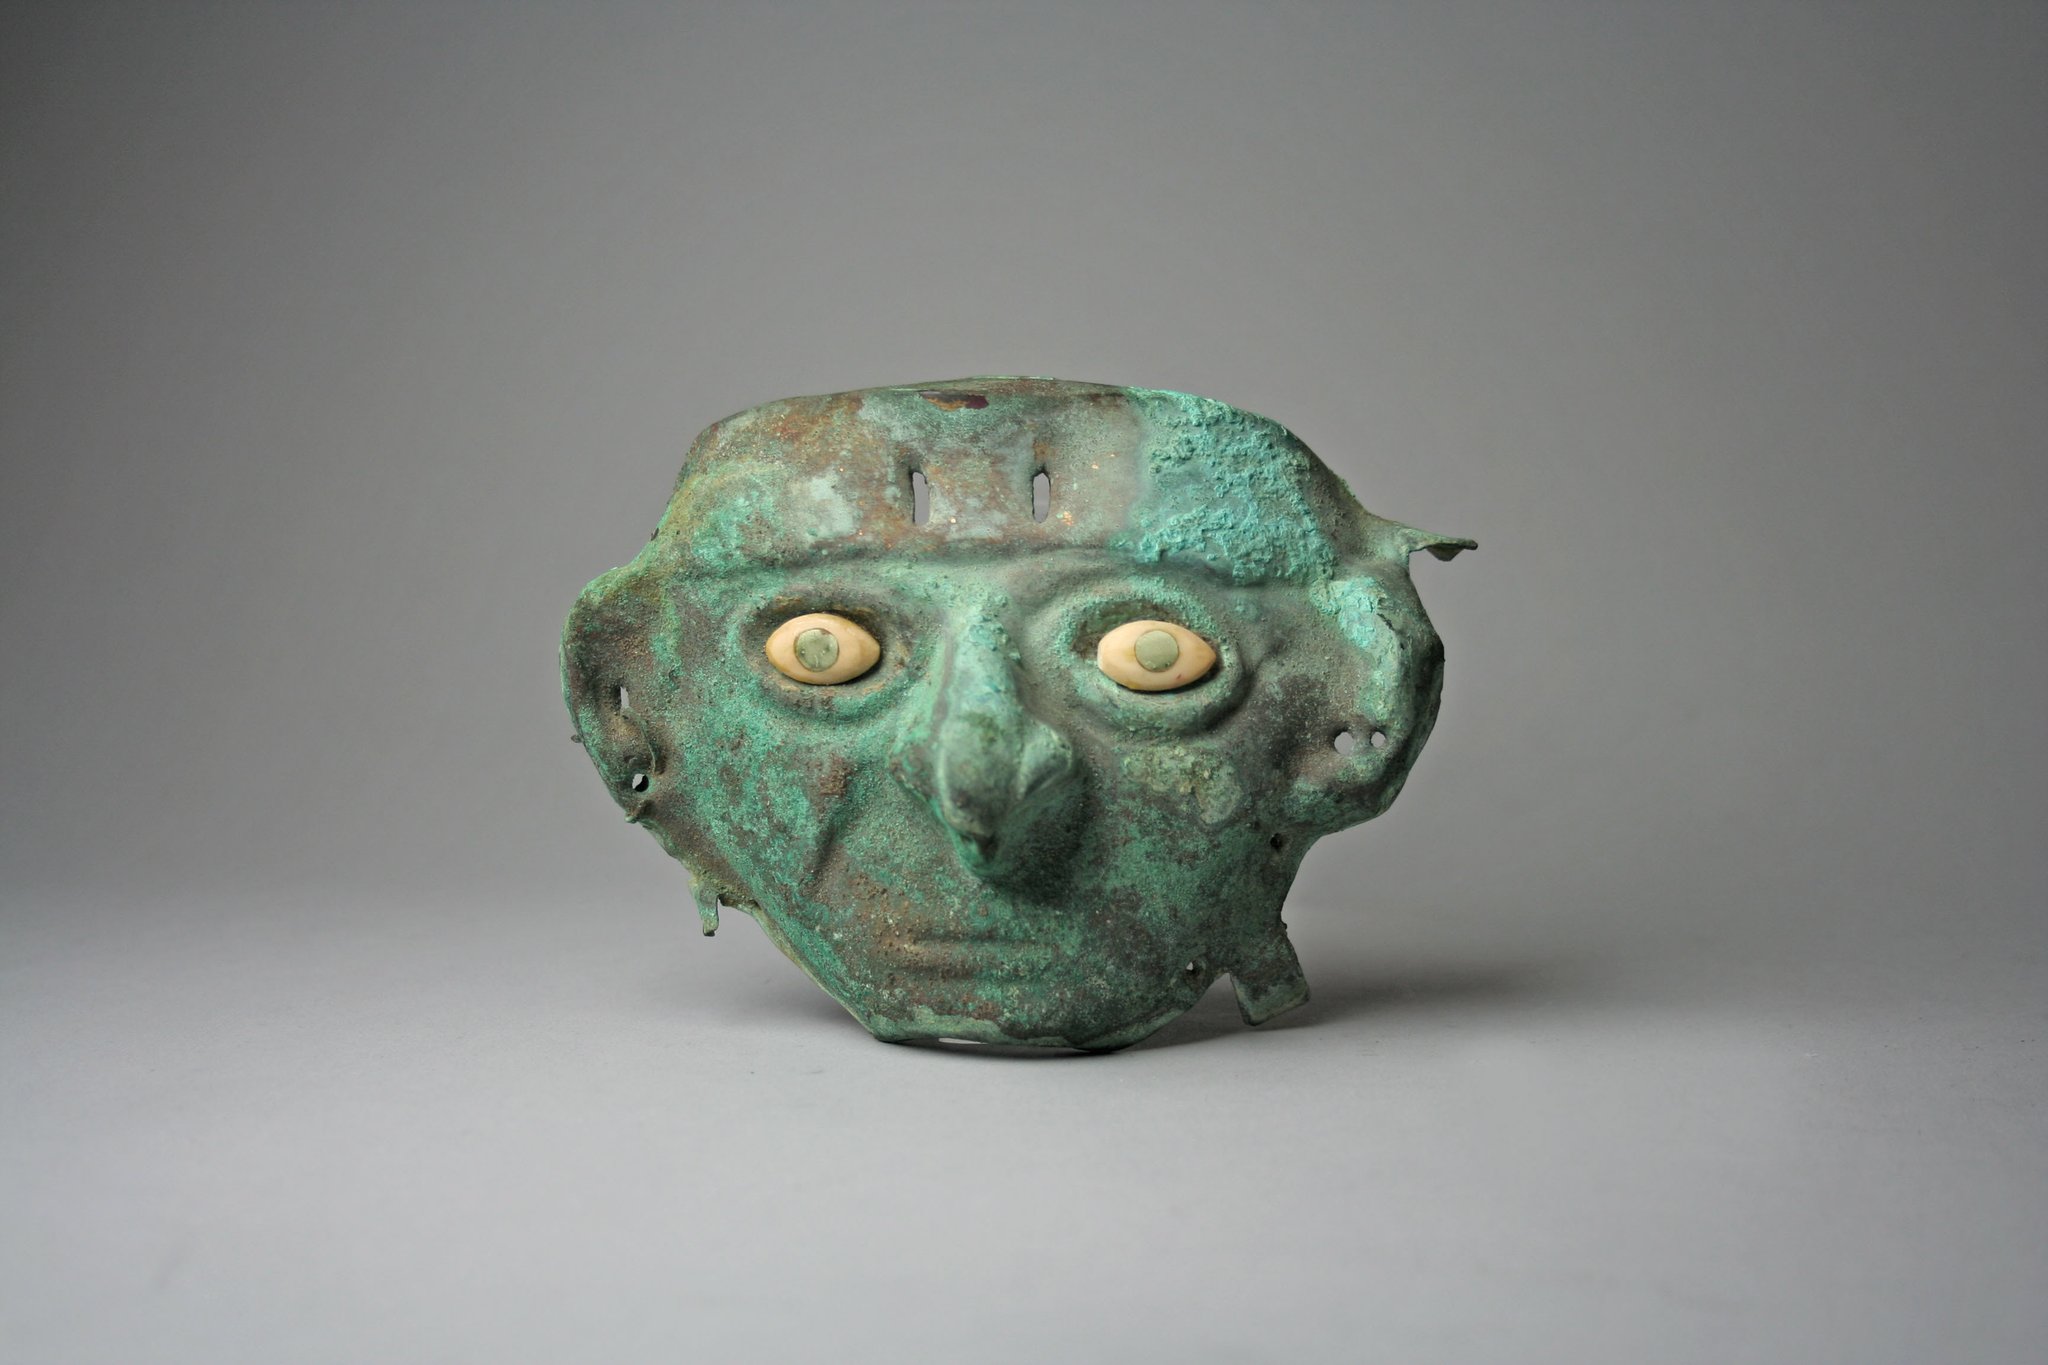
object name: ornament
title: Face Mask Ornament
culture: moche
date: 501-700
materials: gilt copper, shell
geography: peru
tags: faces